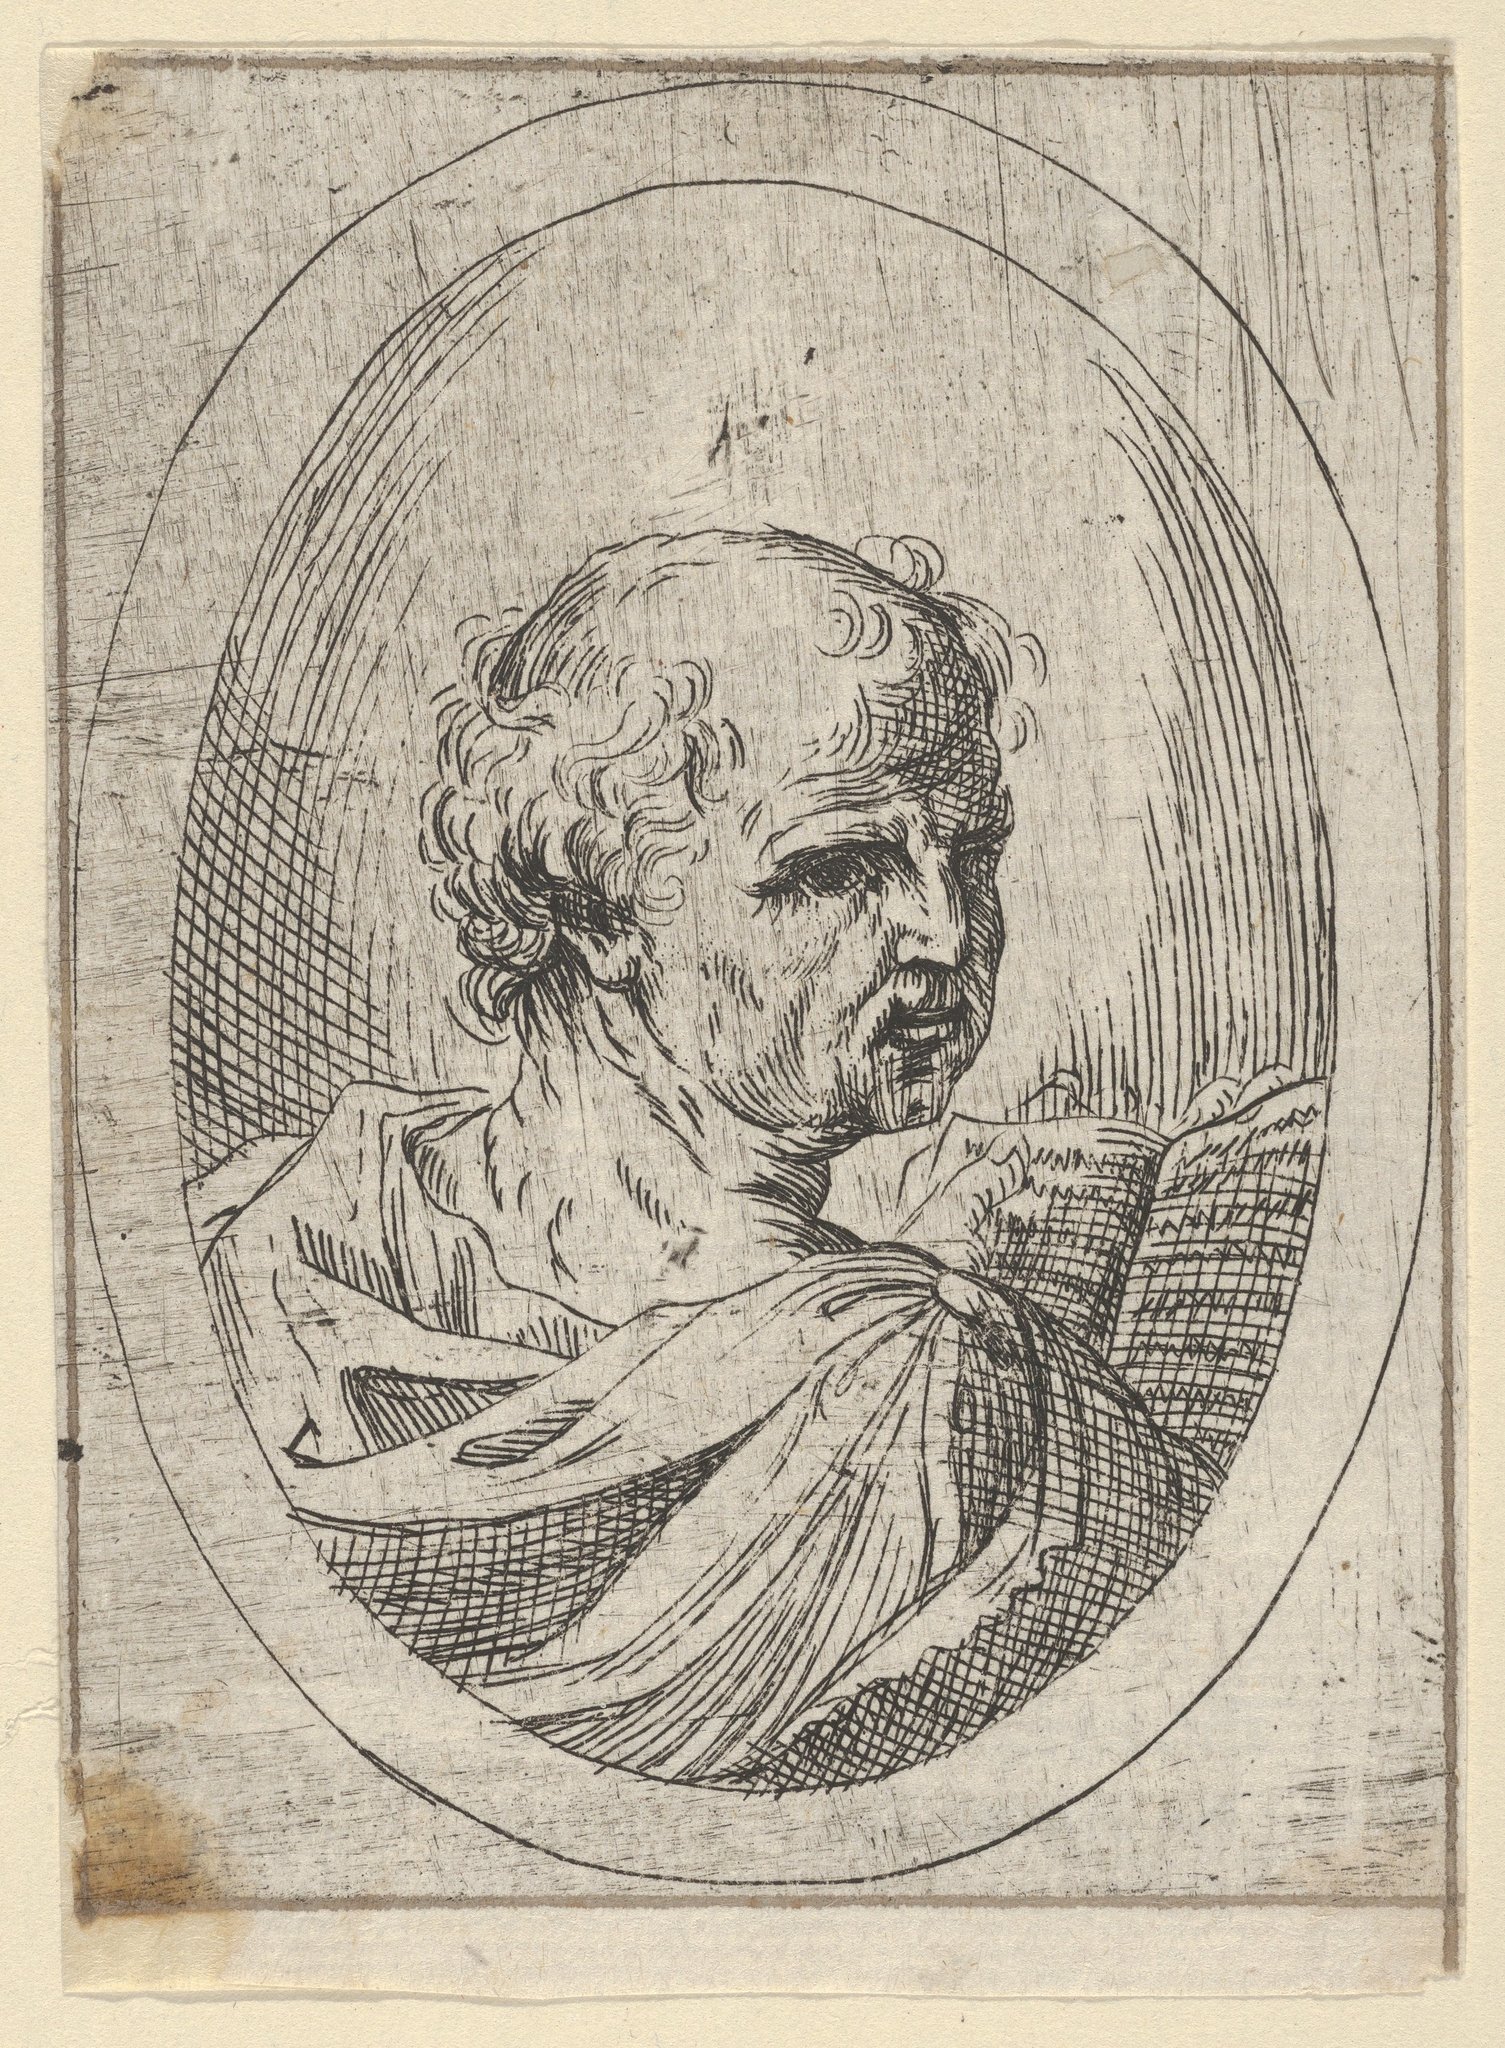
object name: print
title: An apostle seen from behind and turning to the right, holding an open book, in an oval frame, from "Christ, the Virgin, and Thirteen Apostles"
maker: anonymous, 17th century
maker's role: artist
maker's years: 1600-1700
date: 1600-1640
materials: ink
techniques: etching, pen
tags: apostles